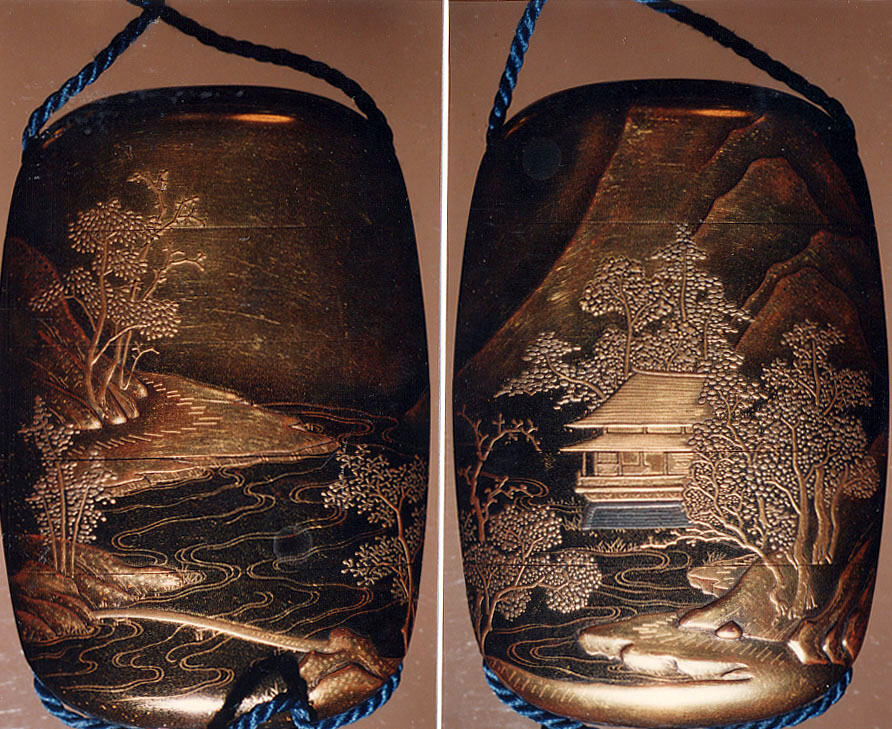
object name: inrō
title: Case (Inrō) with Design of Building beside Winding River in Mountain Landscape and Full Moon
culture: japanese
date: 1801-2000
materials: gold, lacquer, silver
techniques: fundame, hiramakie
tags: rivers,mountains,landscapes,trees